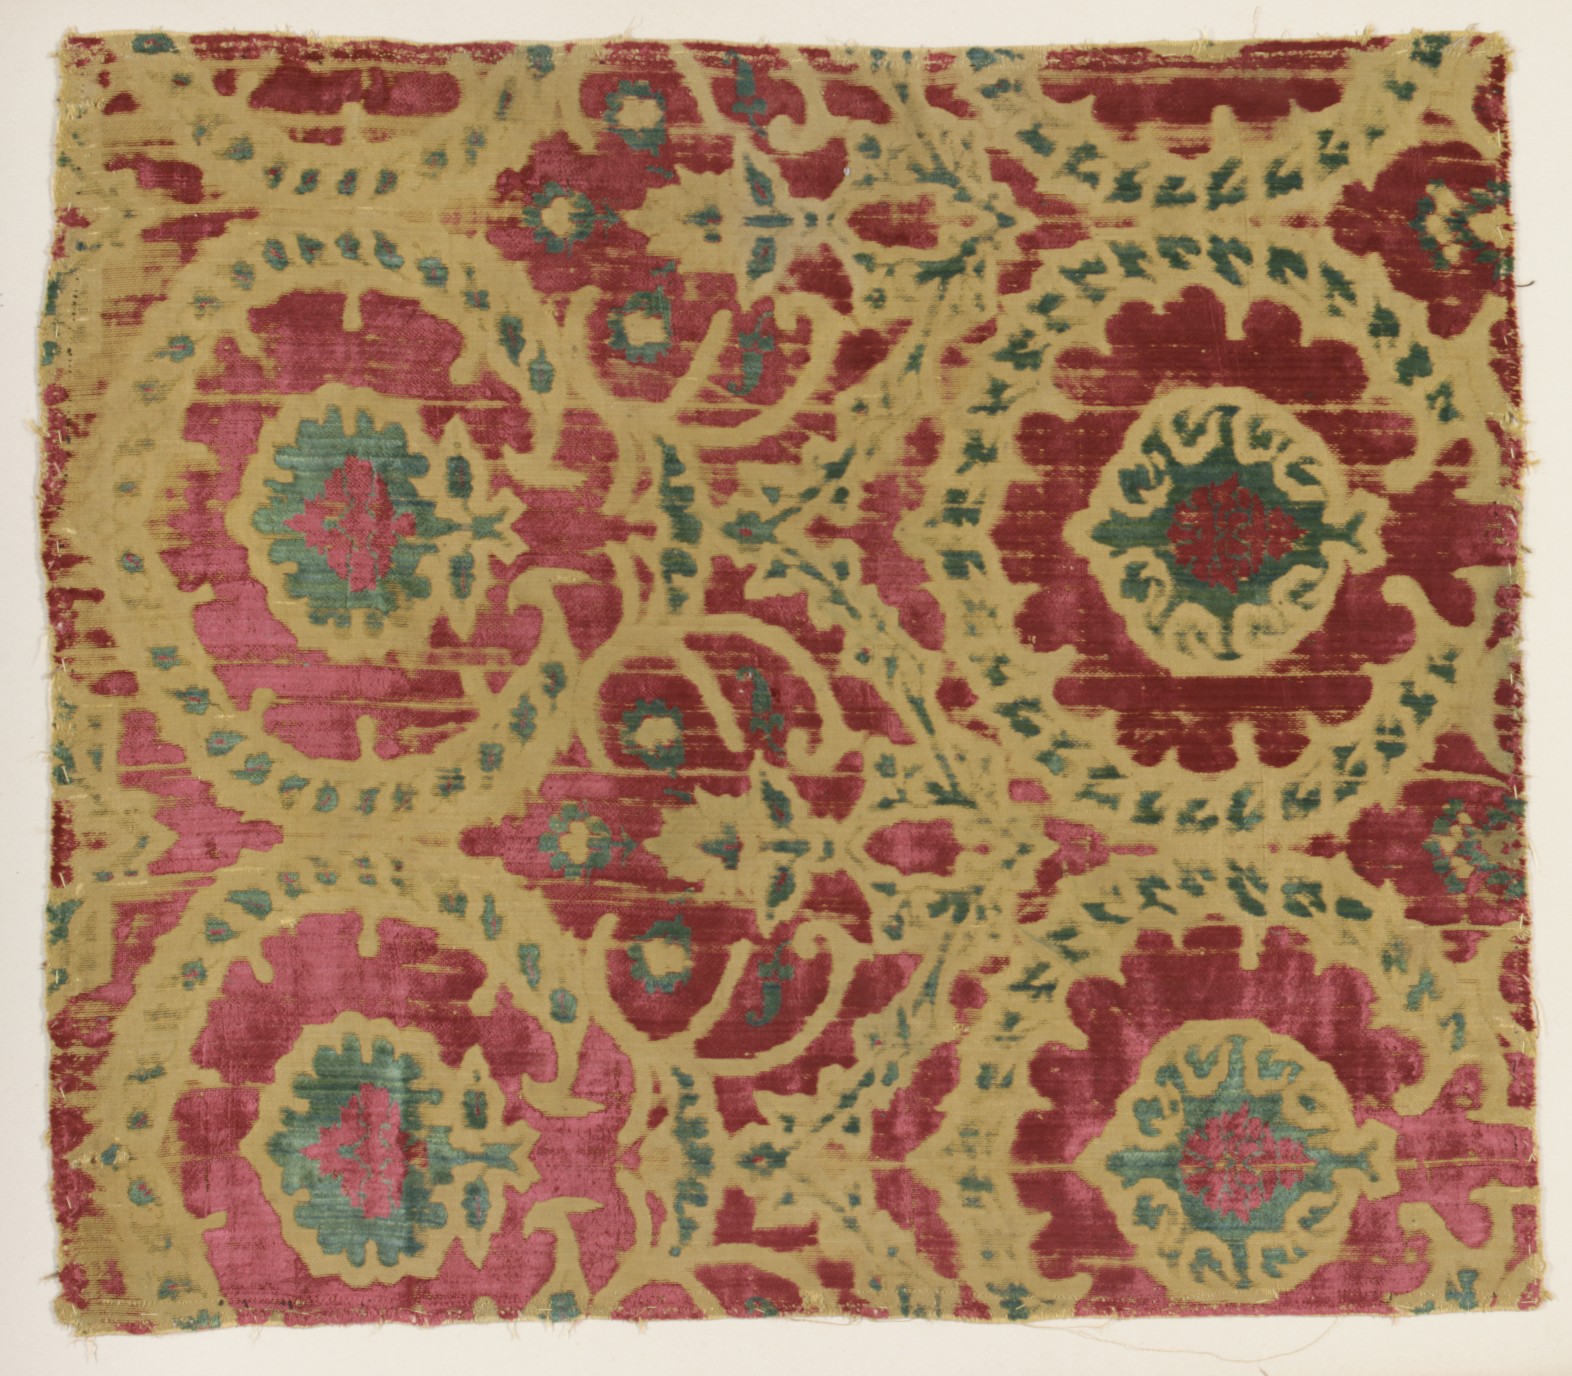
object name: fragment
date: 1401-1600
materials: silk